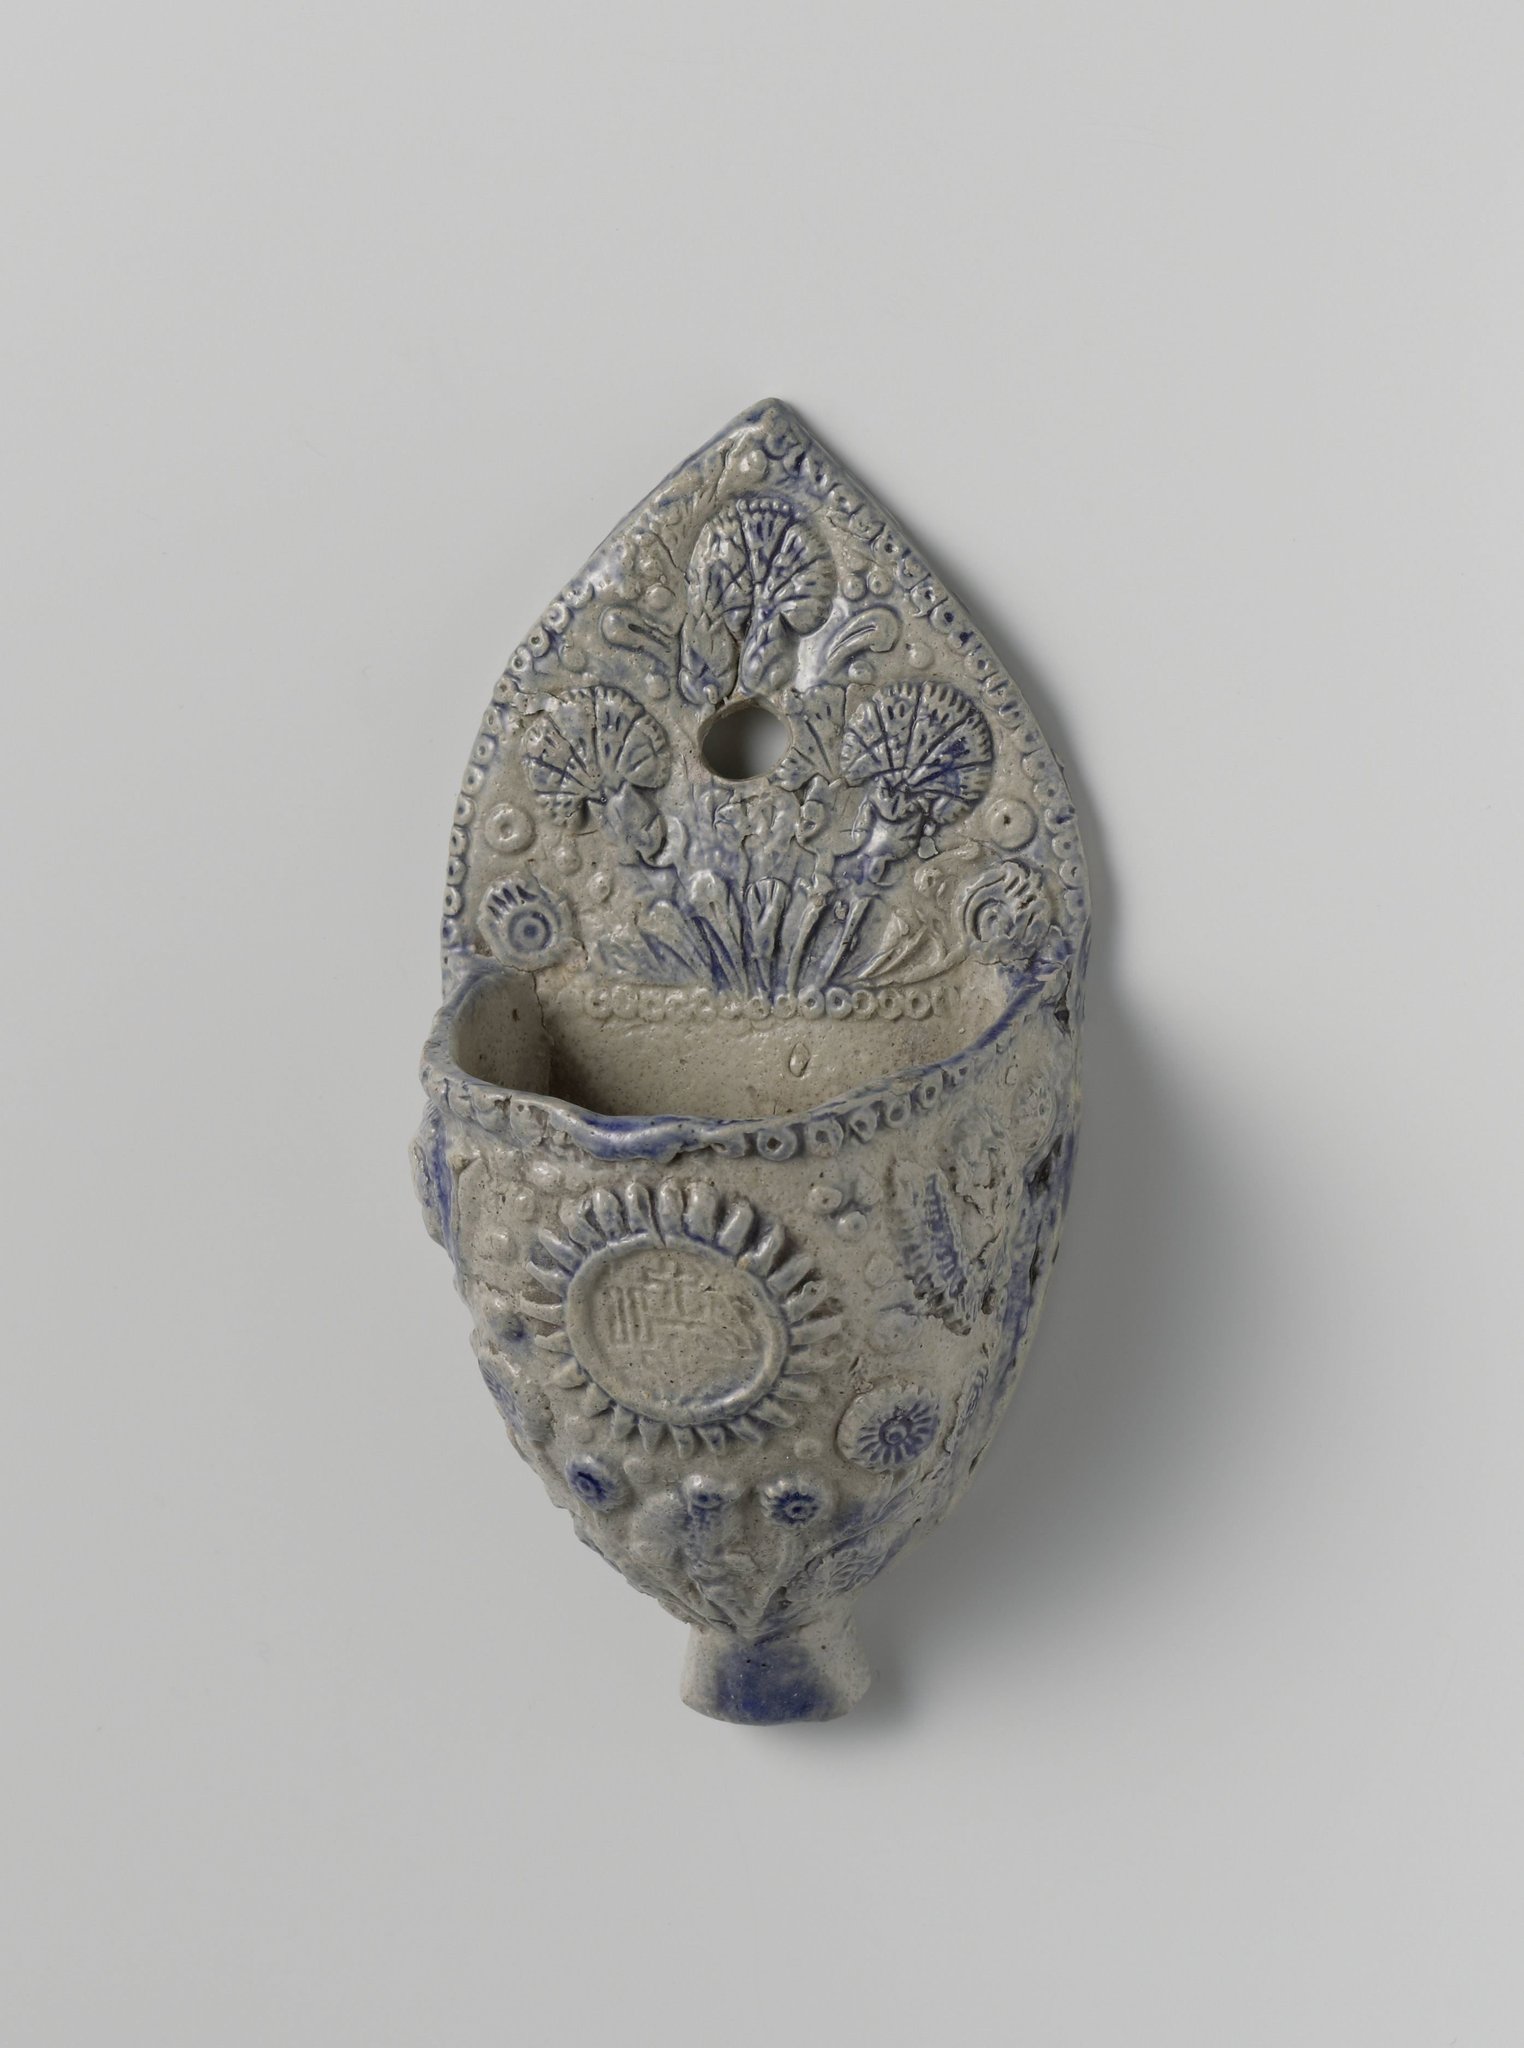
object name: holy water stoup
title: Holy water stoup with angel's heads and flowering plants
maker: Anonymous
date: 1750-1799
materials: cobalt, glaze, stoneware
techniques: firing, forming, relief, vitrification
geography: westerwald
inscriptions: inscription: ‘IHS’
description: Wijwaterbak van steengoed met een halfrond bekken. Gedecoreerd in kobaltblauw. Op het bekken in reliëf gedrukt en opgelegd het kruis en het opschrift 'IHS', omgeven door engelenkoppen en bloeiende planten. De achterplaat tevens met een bloeiende plant. Westerwald.